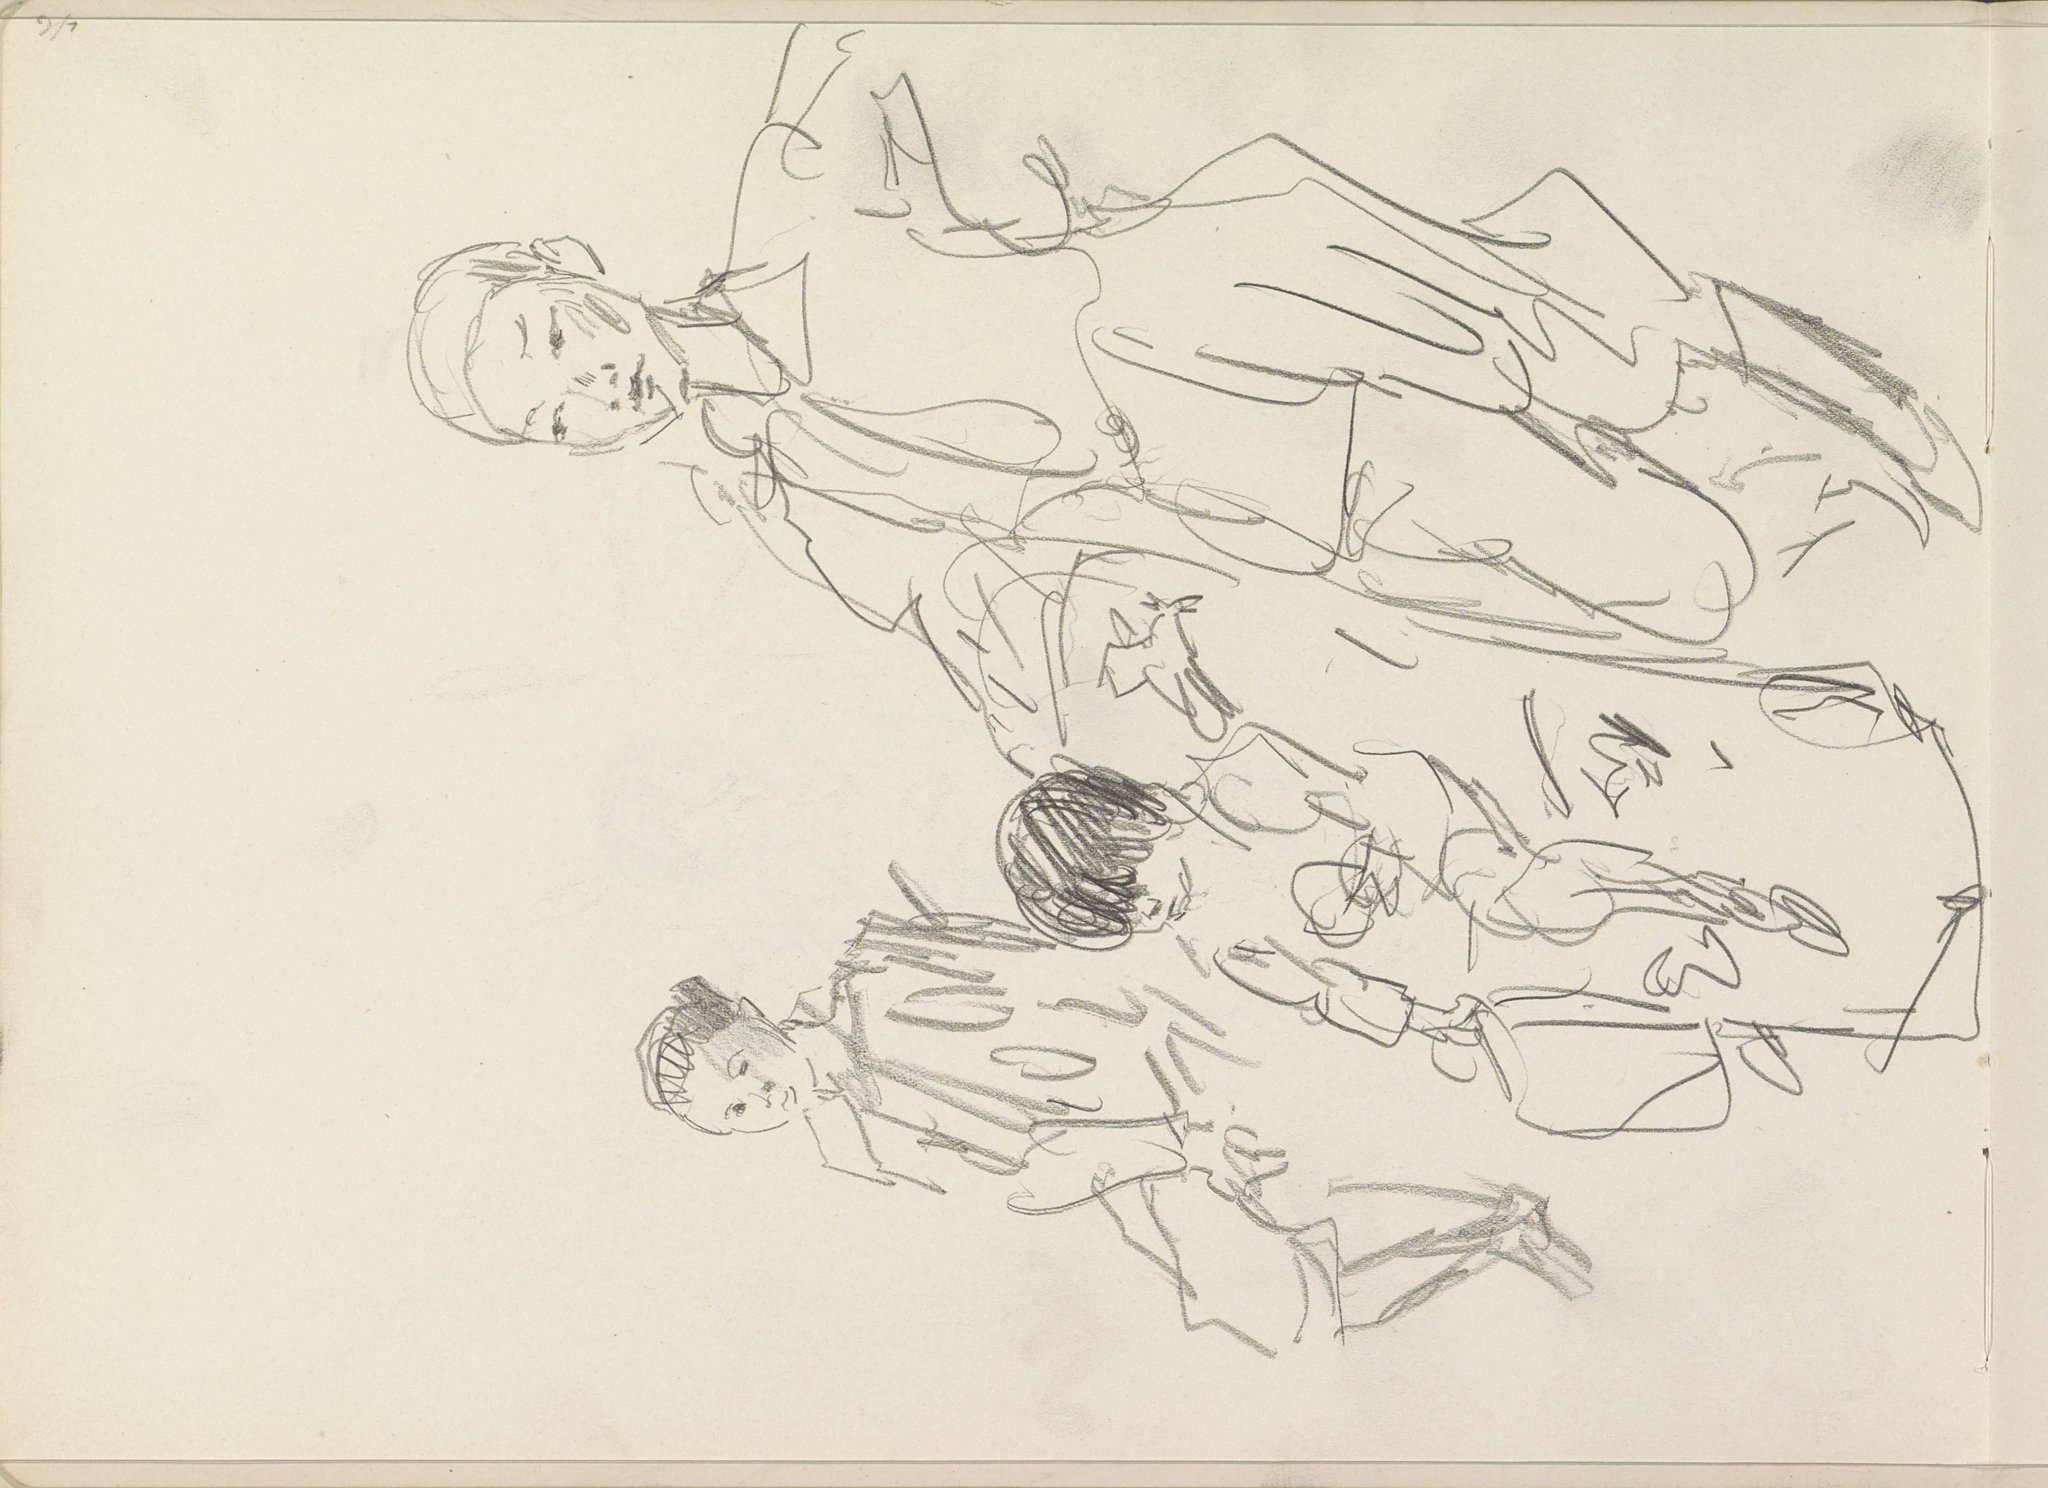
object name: sketchbook leaf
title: Twee zittende jongens en een staande man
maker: isaac israels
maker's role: draughtsman, painter, print maker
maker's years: 1865-1934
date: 1875-1934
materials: paper, pencil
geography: the hague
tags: standing figure, boy (child between toddler and youth) (+ sitting)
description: De man is mogelijk Indisch. Blad 21 verso uit schetsboek V met 33 bladen.